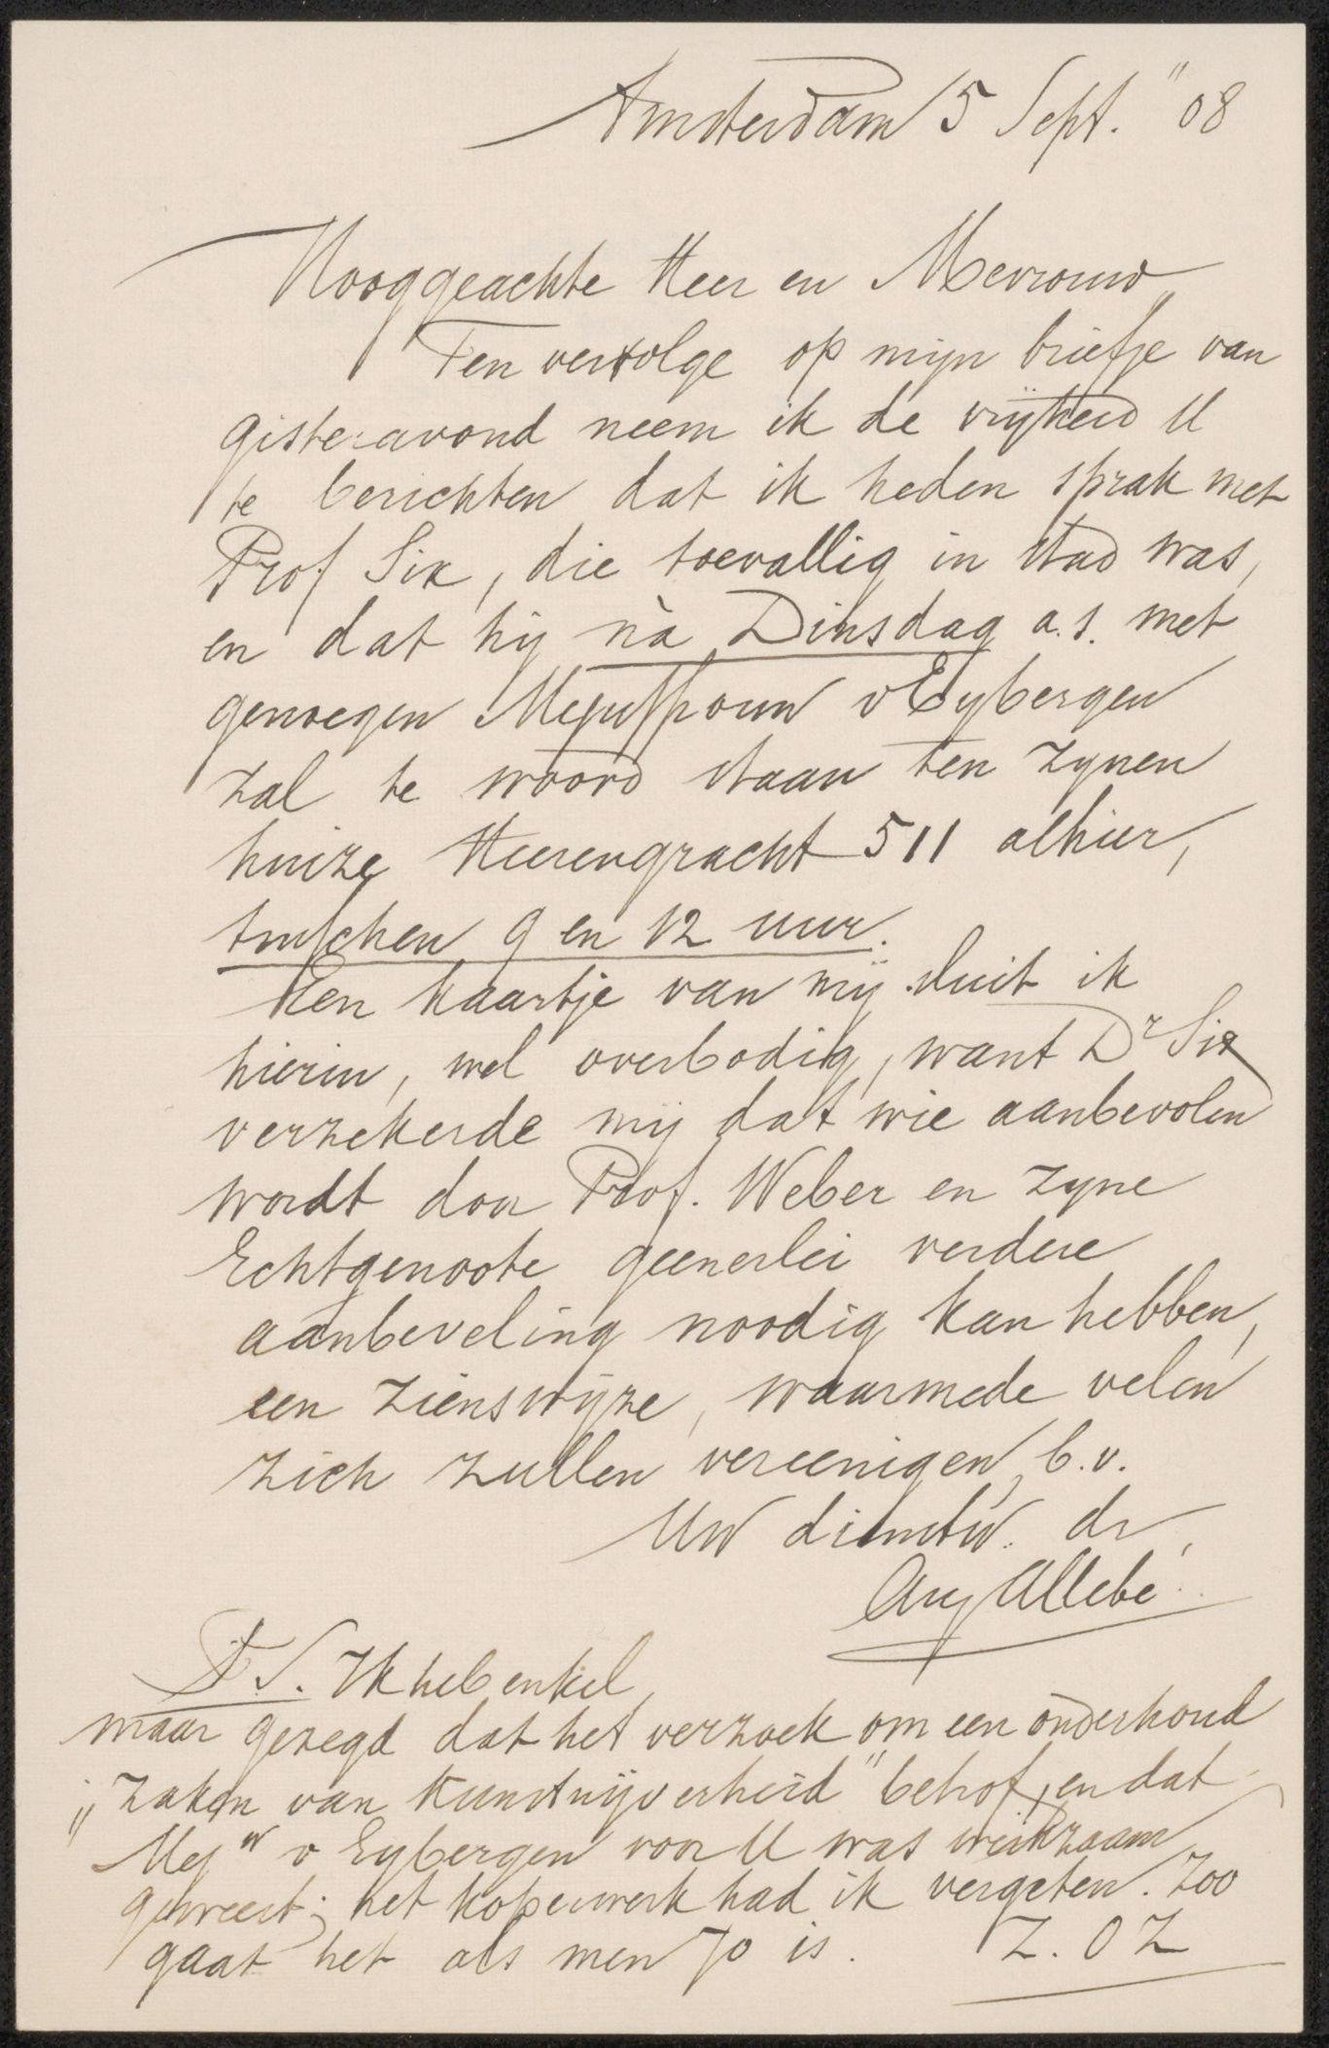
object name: letter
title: Brief aan Max Wilhelm Carl Weber en Anne Antoinette Weber-Van Bosse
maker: august allebé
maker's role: draughtsman, print maker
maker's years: 1838-1927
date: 1908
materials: ink, paper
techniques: pen, writing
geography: amsterdam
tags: anne antoinette weber-van bosse, amsterdam, jonkheer jan six, applied arts, arts and crafts; industrial design